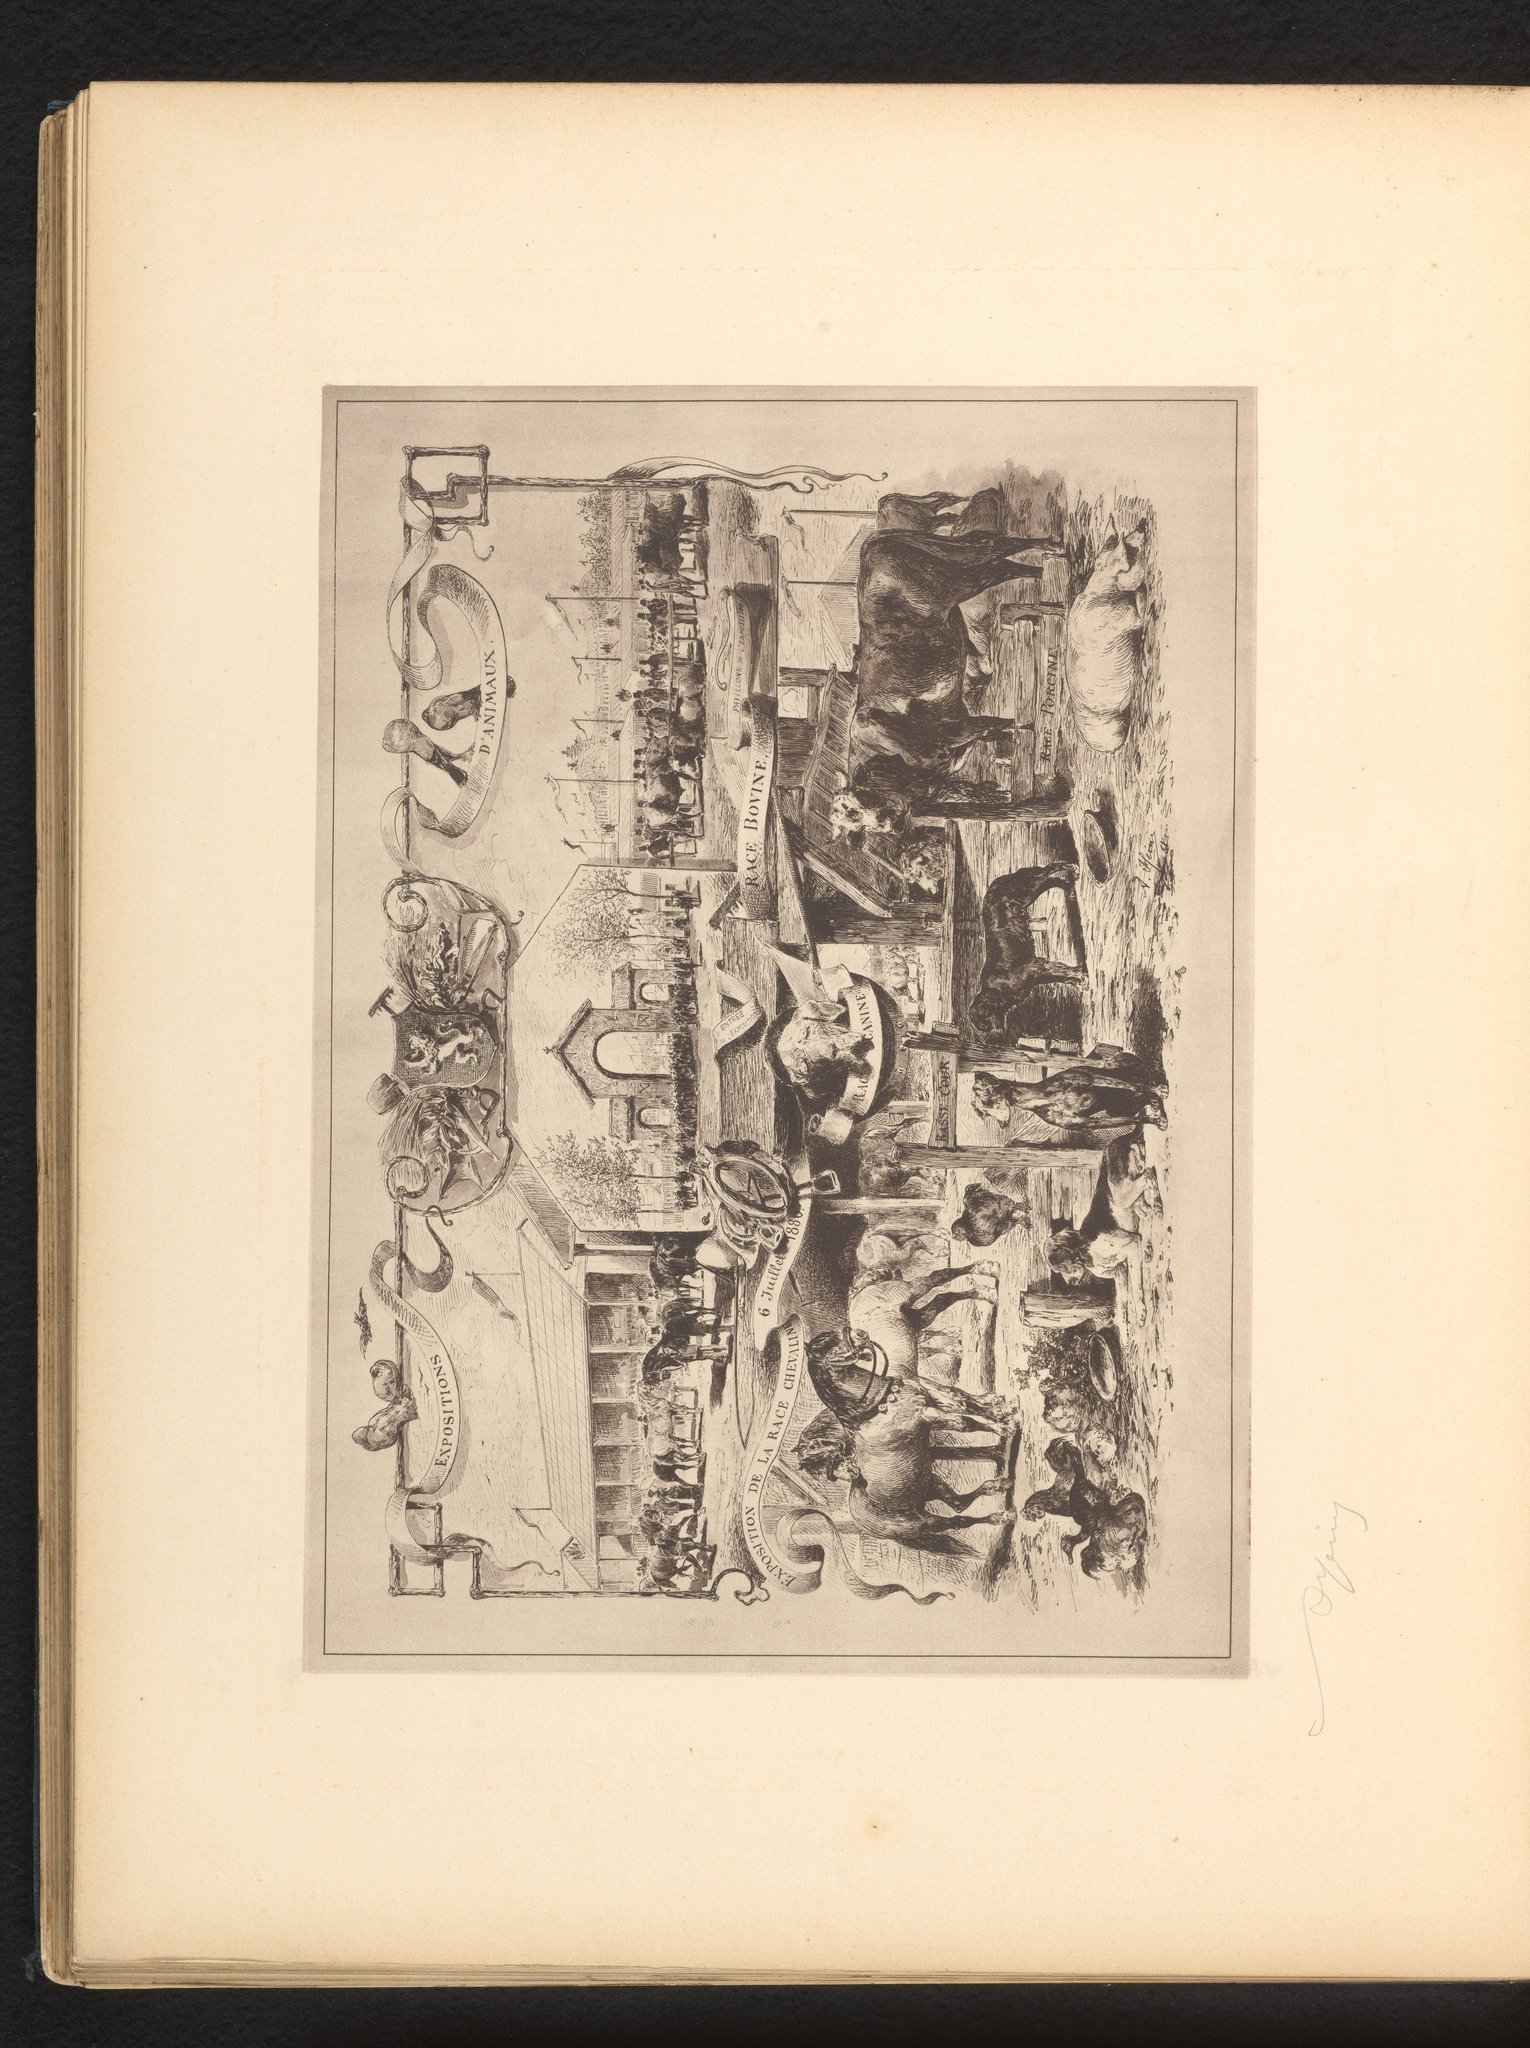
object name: page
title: Reproductie van een gravure van verschillende soorten dieren, getoond op de Exposition Nationale van 1880 in Brussel, door Armand Heins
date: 1881-1882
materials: paper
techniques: photograph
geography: brussels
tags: animals, trade exhibition, industries fair, brussels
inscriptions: name: ‘Heins’